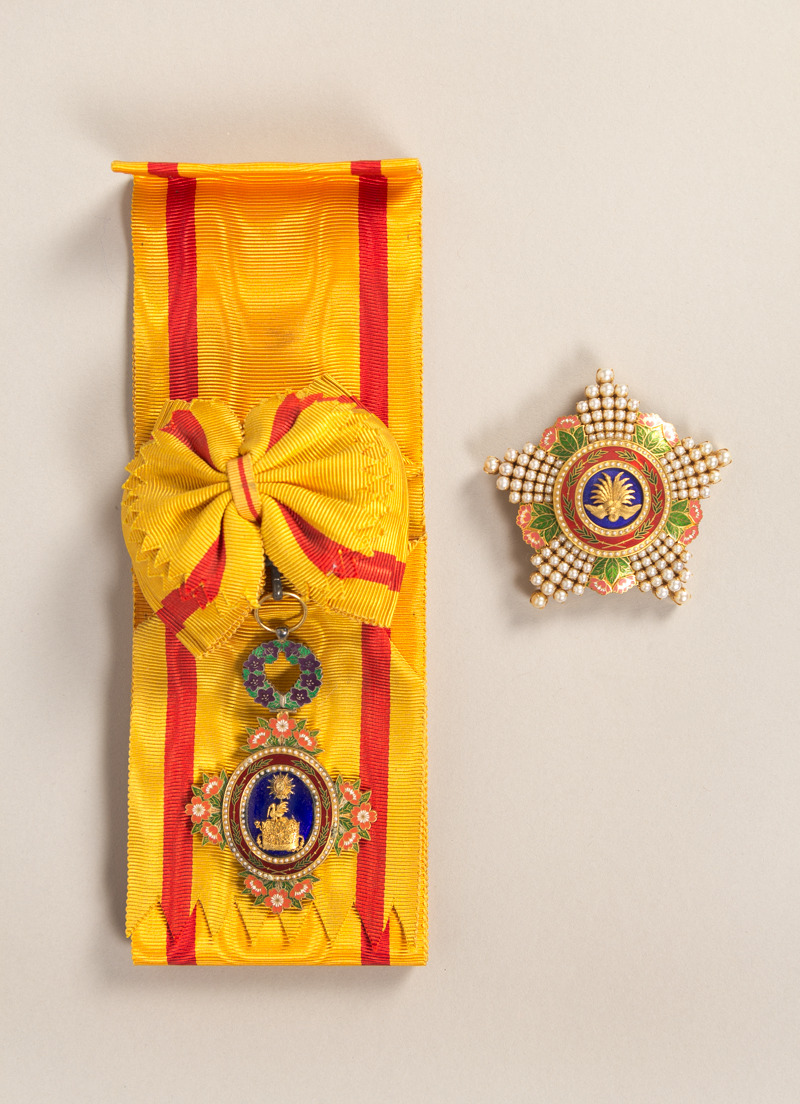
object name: insignia and medal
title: Insignia of the Order of the Precious Crown, Paulownia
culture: japanese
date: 1867-1900